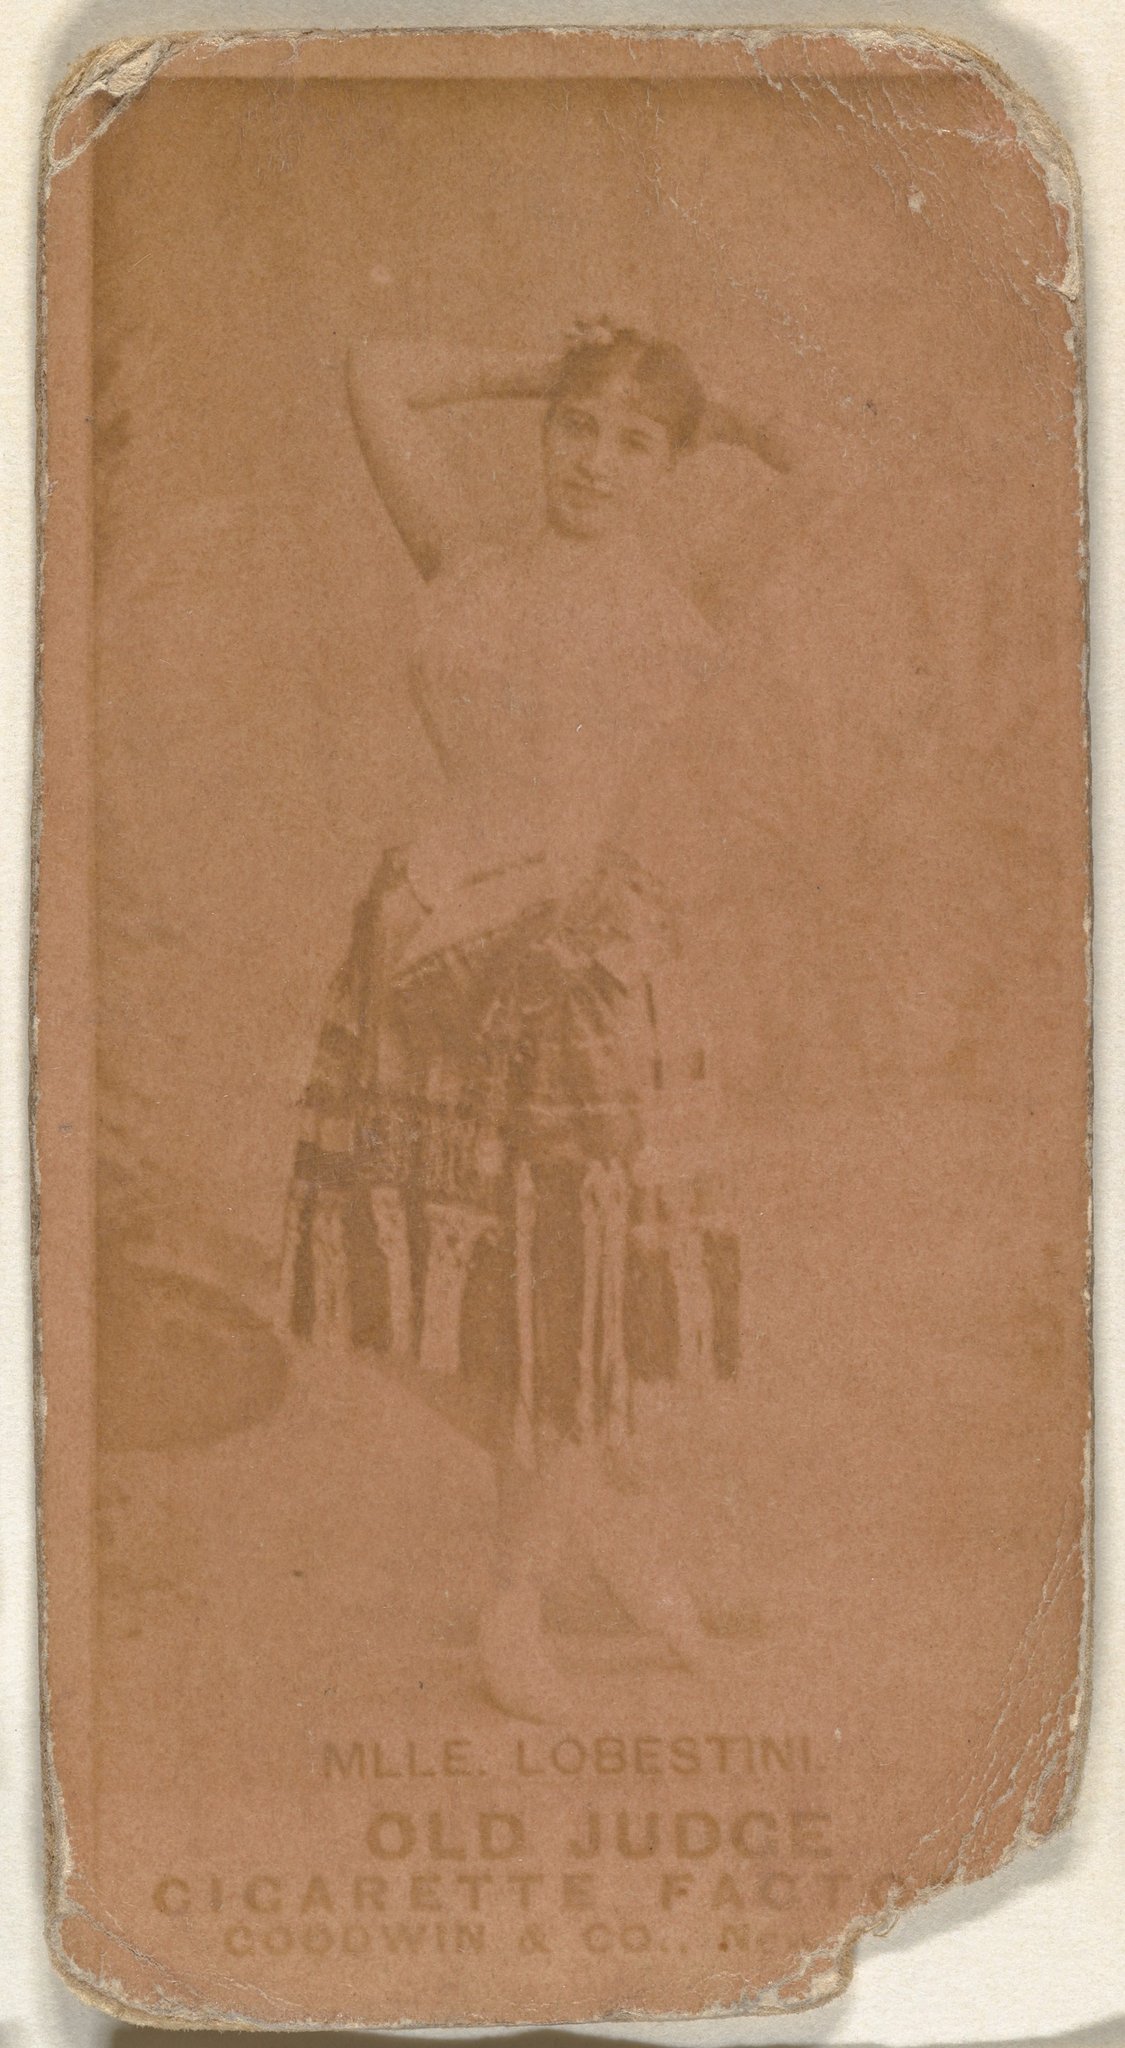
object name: photograph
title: Mlle. Lobestini, from the Actors and Actresses series (N171) for Old Judge Cigarettes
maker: goodwin & company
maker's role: publisher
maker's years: 1850-1950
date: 1886-1890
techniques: albumen silver print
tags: portraits,women,actresses